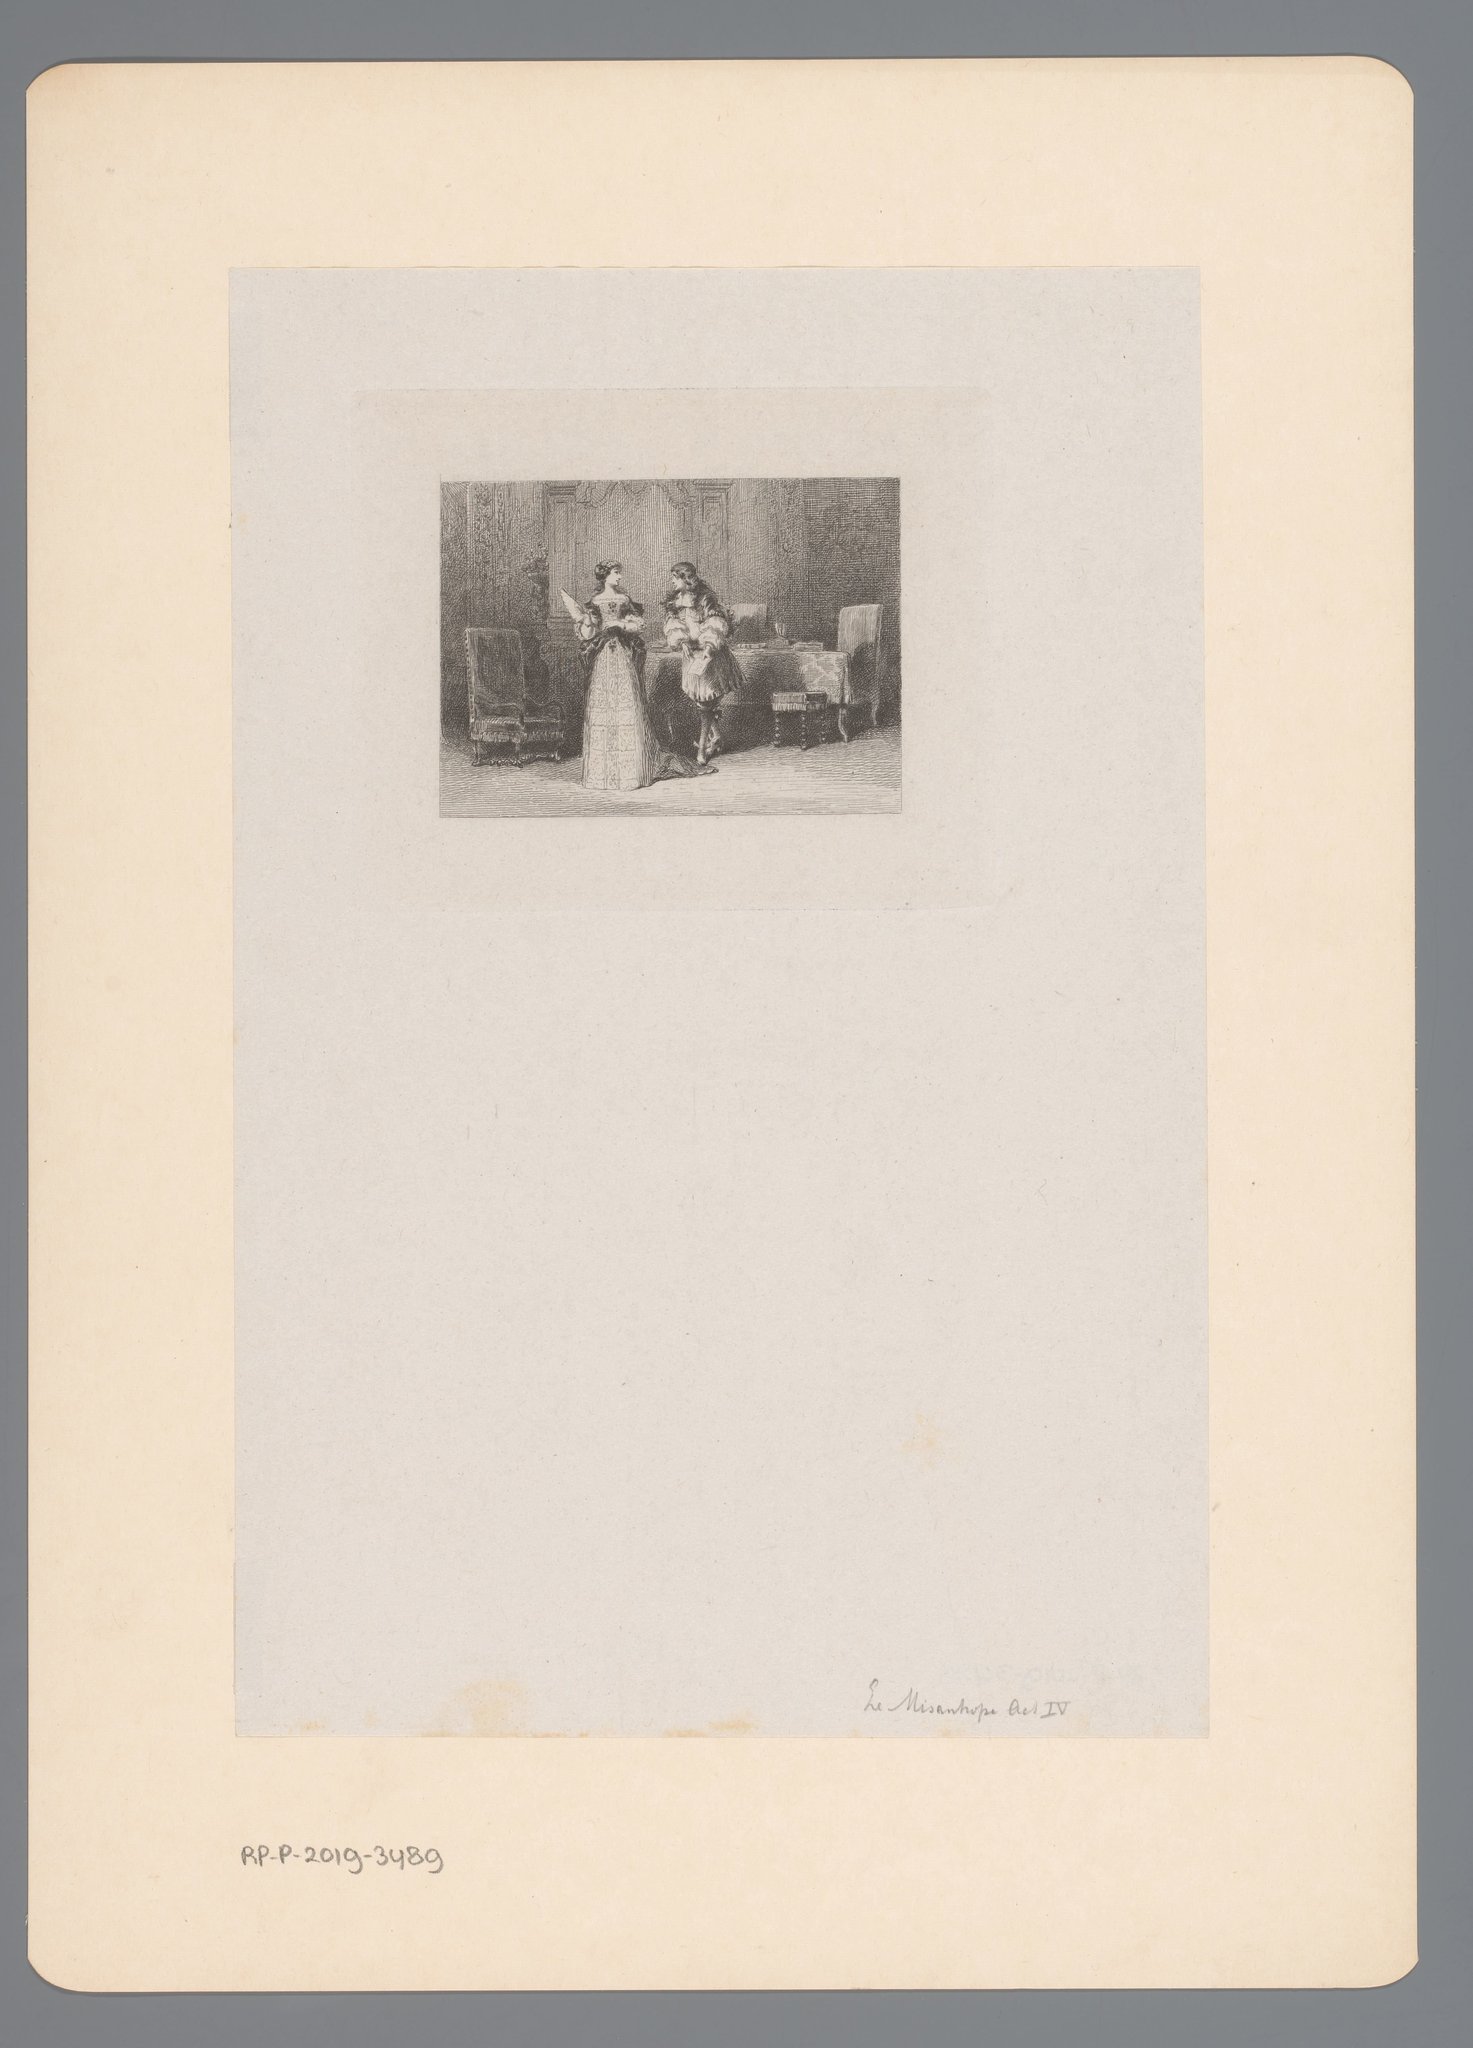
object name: print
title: Molière Théatre Choisi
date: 1878-1879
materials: paper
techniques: drypoint, etching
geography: tours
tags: theatre, theatrical performance, fan, courting, letter, envelope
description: Scène uit akte IV uit "Le Misanthrope" van Molière.